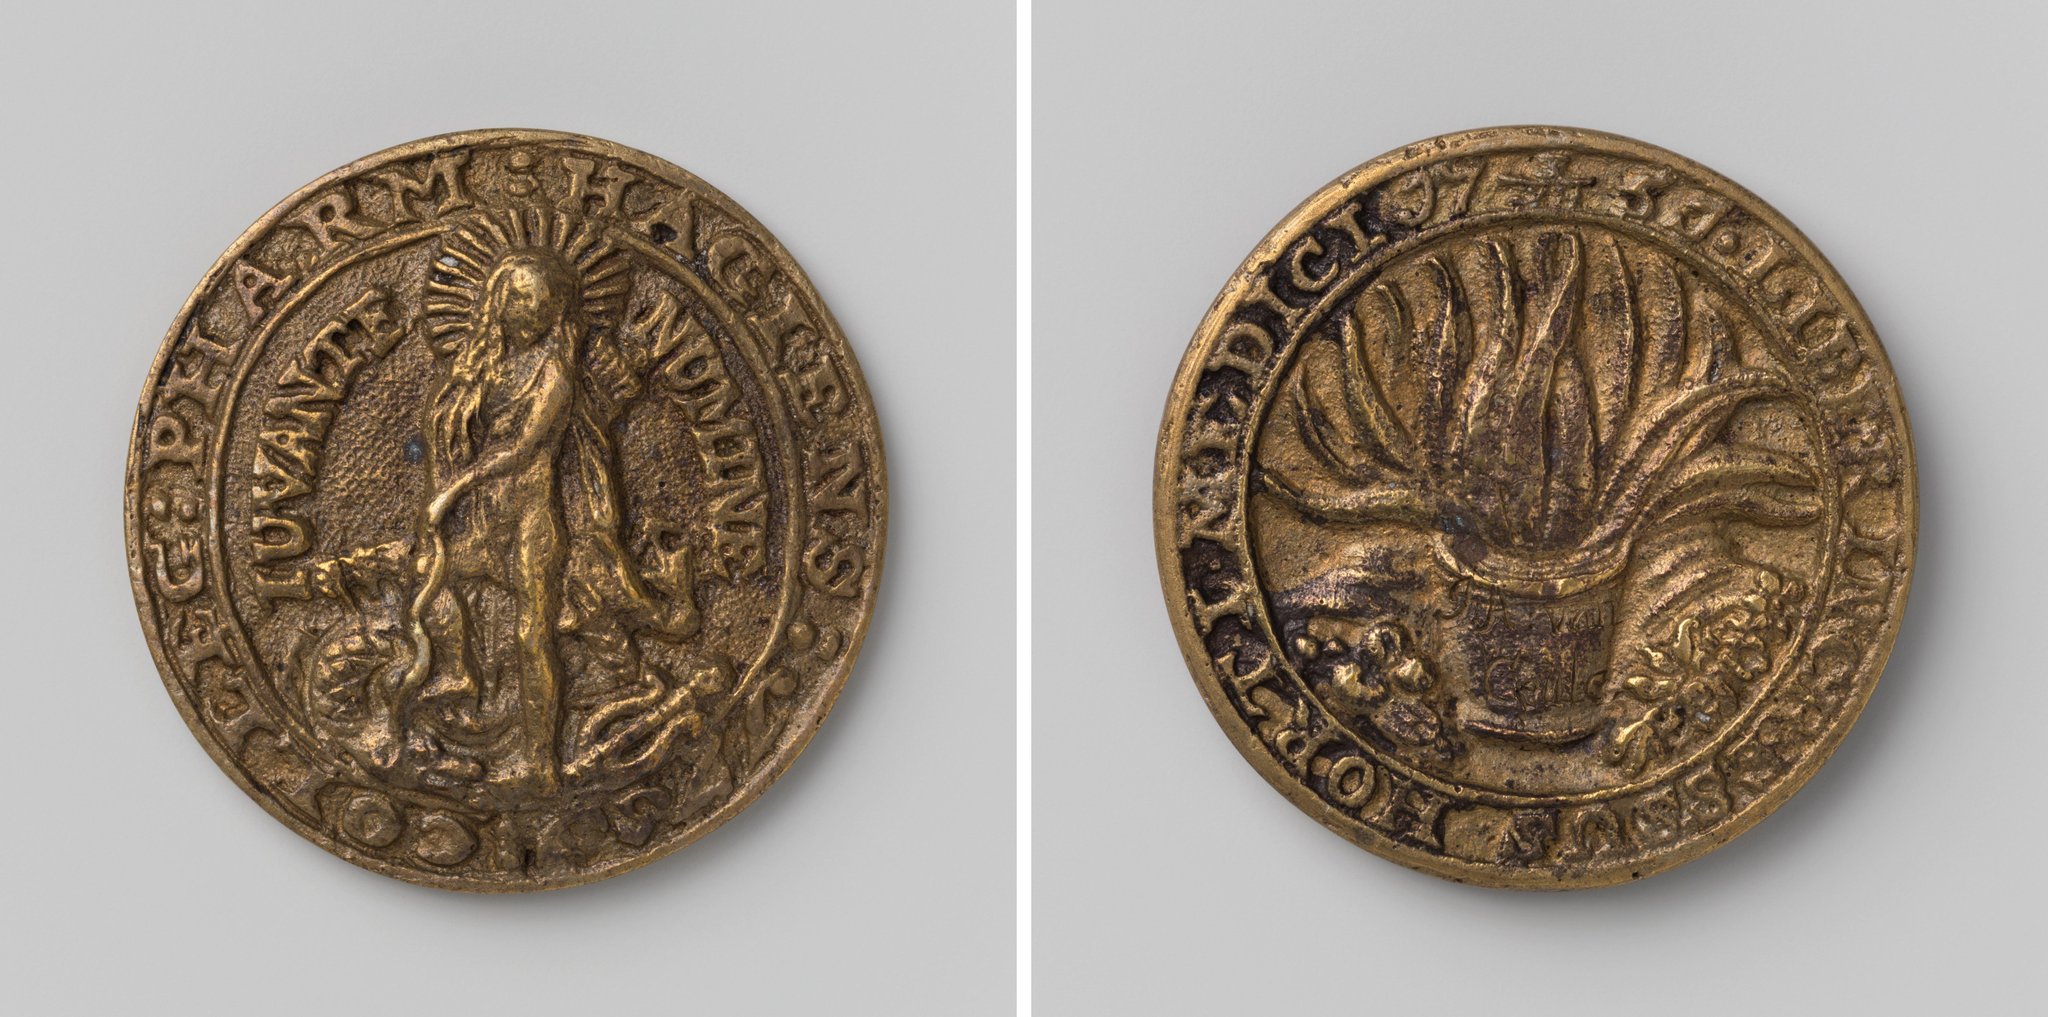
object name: toegangspenning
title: Collegium Pharmaceuticum te 's-Gravenhage, toegangspenning voor de hortus medicus voor J.A. van Ceule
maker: Anonymous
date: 1751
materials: brass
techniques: casting, engraving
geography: the hague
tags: the hague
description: Guilds were urban organisations of people in specific occupations. The guild represented the interests of the profession. Each member had a token as proof of membership. The person’s name was engraved on one side of the token, often together with the arms of the guild or of the city in which it was based. The other side carried a motif signifying the occupation represented by the guild.